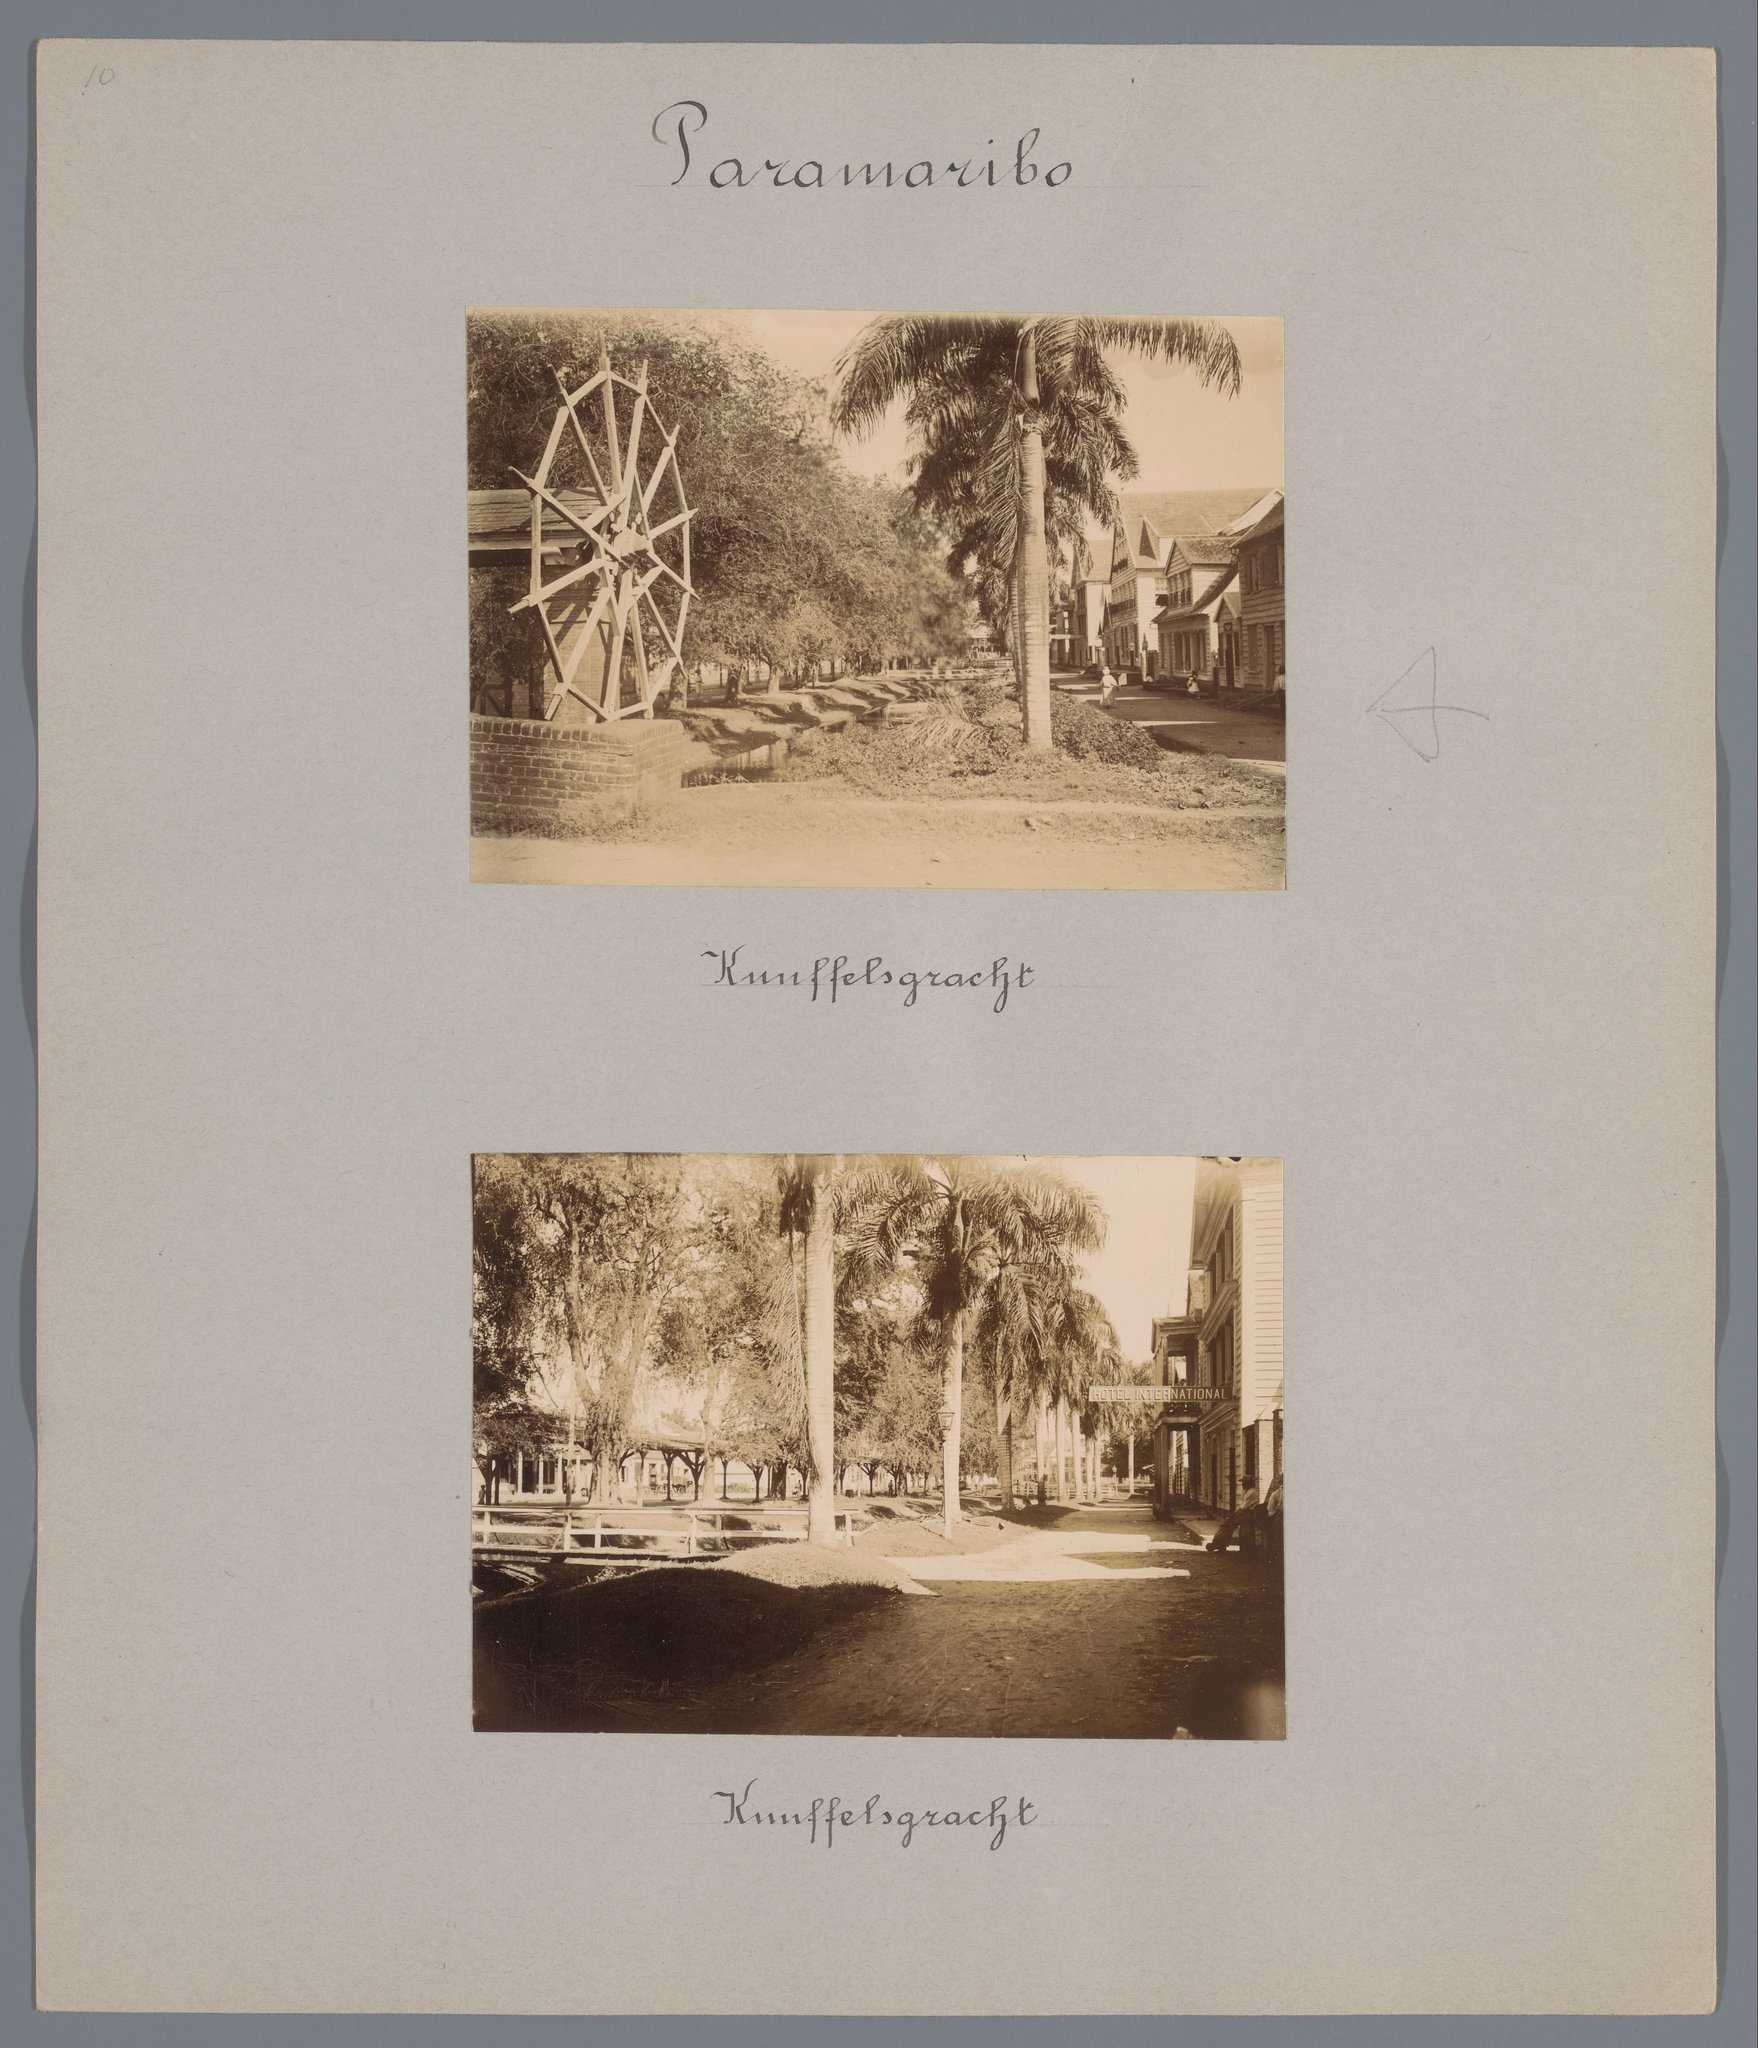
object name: photograph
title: Knuffelsgracht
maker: eugen klein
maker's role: fotograaf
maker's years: 1869-1927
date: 1900-1905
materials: cardboard, photographic support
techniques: gelatin silver print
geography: paramaribo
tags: knuffelsgracht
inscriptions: inscription: ‘Paramaribo / Knuffelsgracht’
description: Gezicht op de Knuffelsgracht te Paramaribo. Onderdeel van een groep van 44 foto's van Paramaribo, Suriname en Curaçao, ca. 1900-1905, opgeplakt op kartons en voorzien van opschriften.